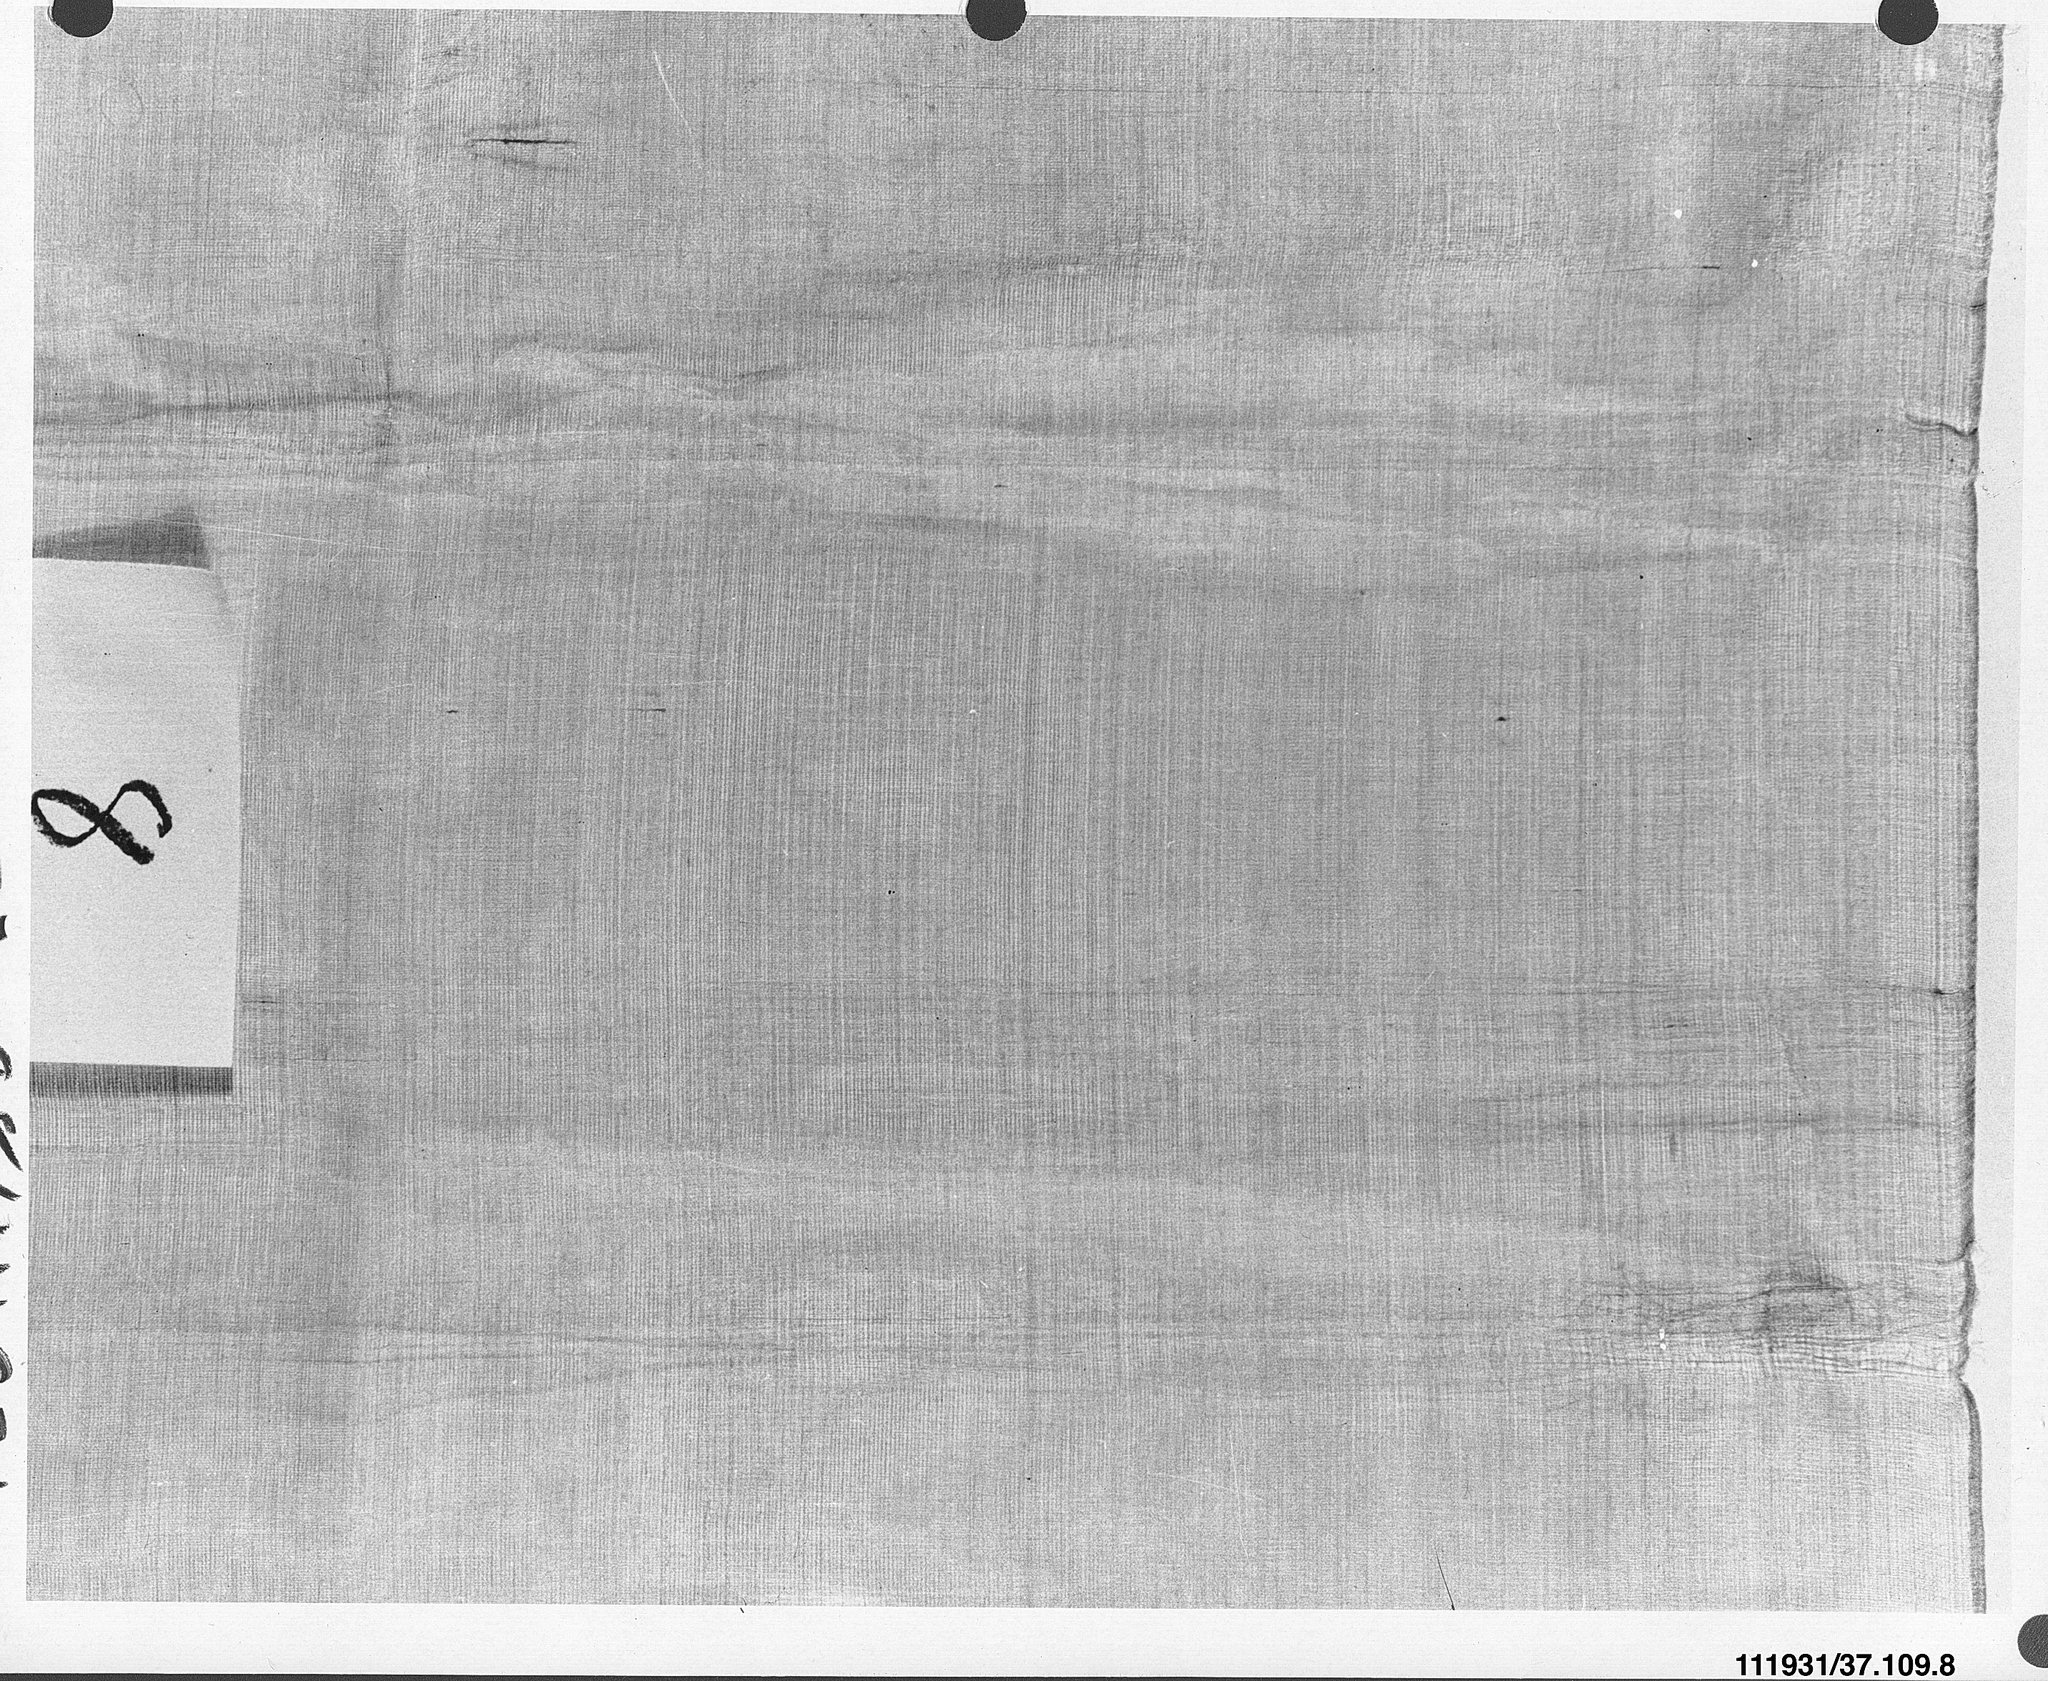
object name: piece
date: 1801-1900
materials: silk